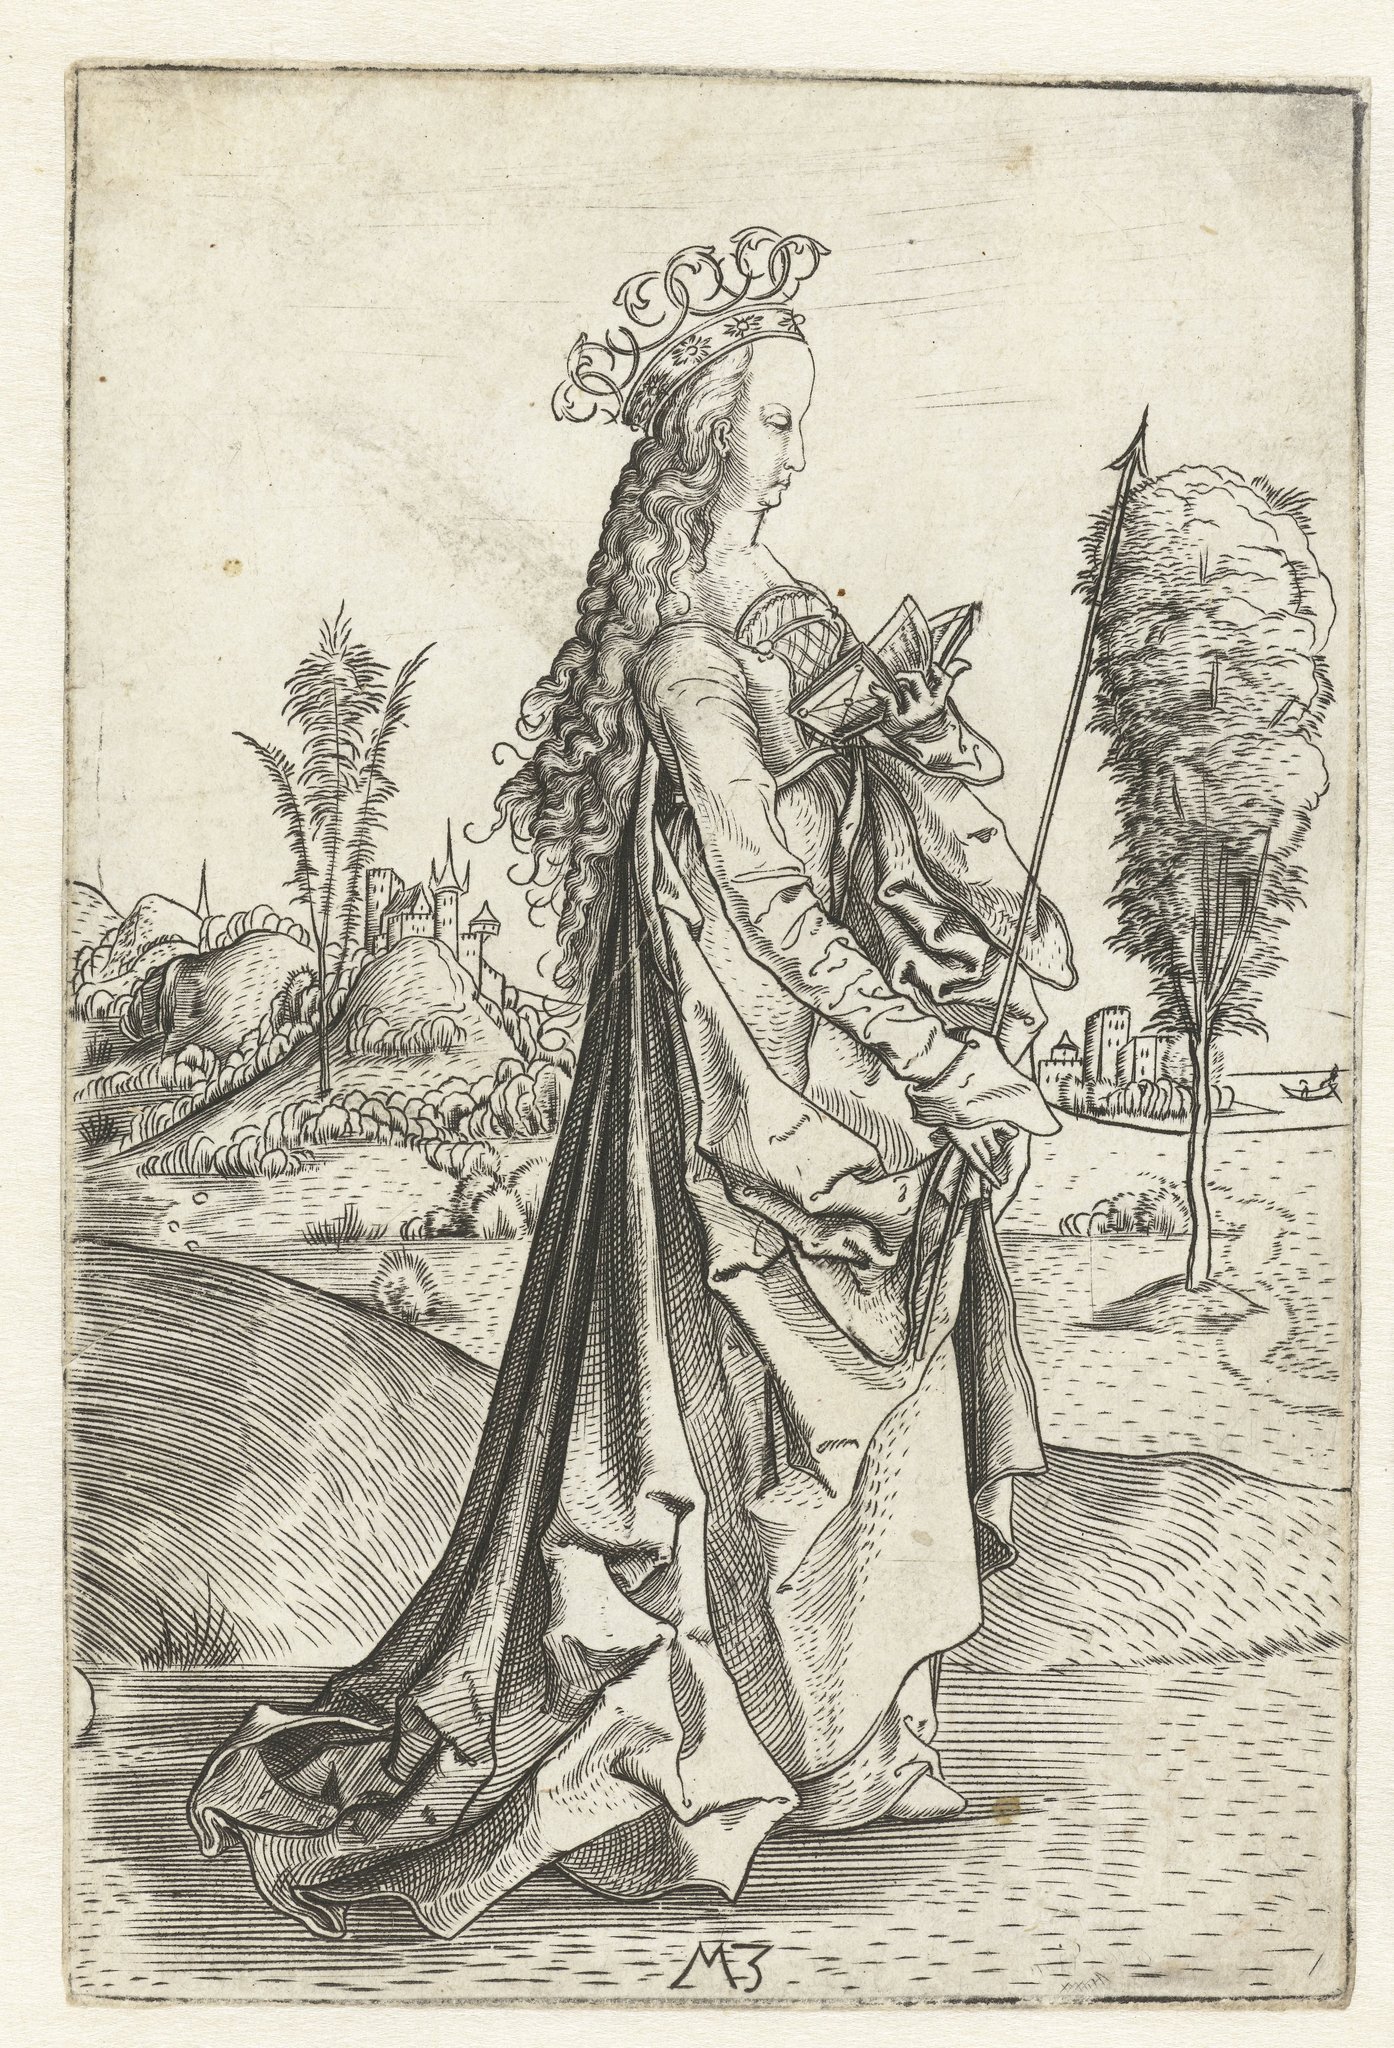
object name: print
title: Heilige Ursula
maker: monogrammist mz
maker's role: print maker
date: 1500-1503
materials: paper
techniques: engraving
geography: germany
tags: the virgin martyr ursula of cologne; possible attributes: arrow, banner with red cross, cloak of ermine, crown, ship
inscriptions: collector's mark: Lugt 240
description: De Heilige Ursula, staand in een landschap, een kroon op het hoofd, een pijl en een boek in de handen.